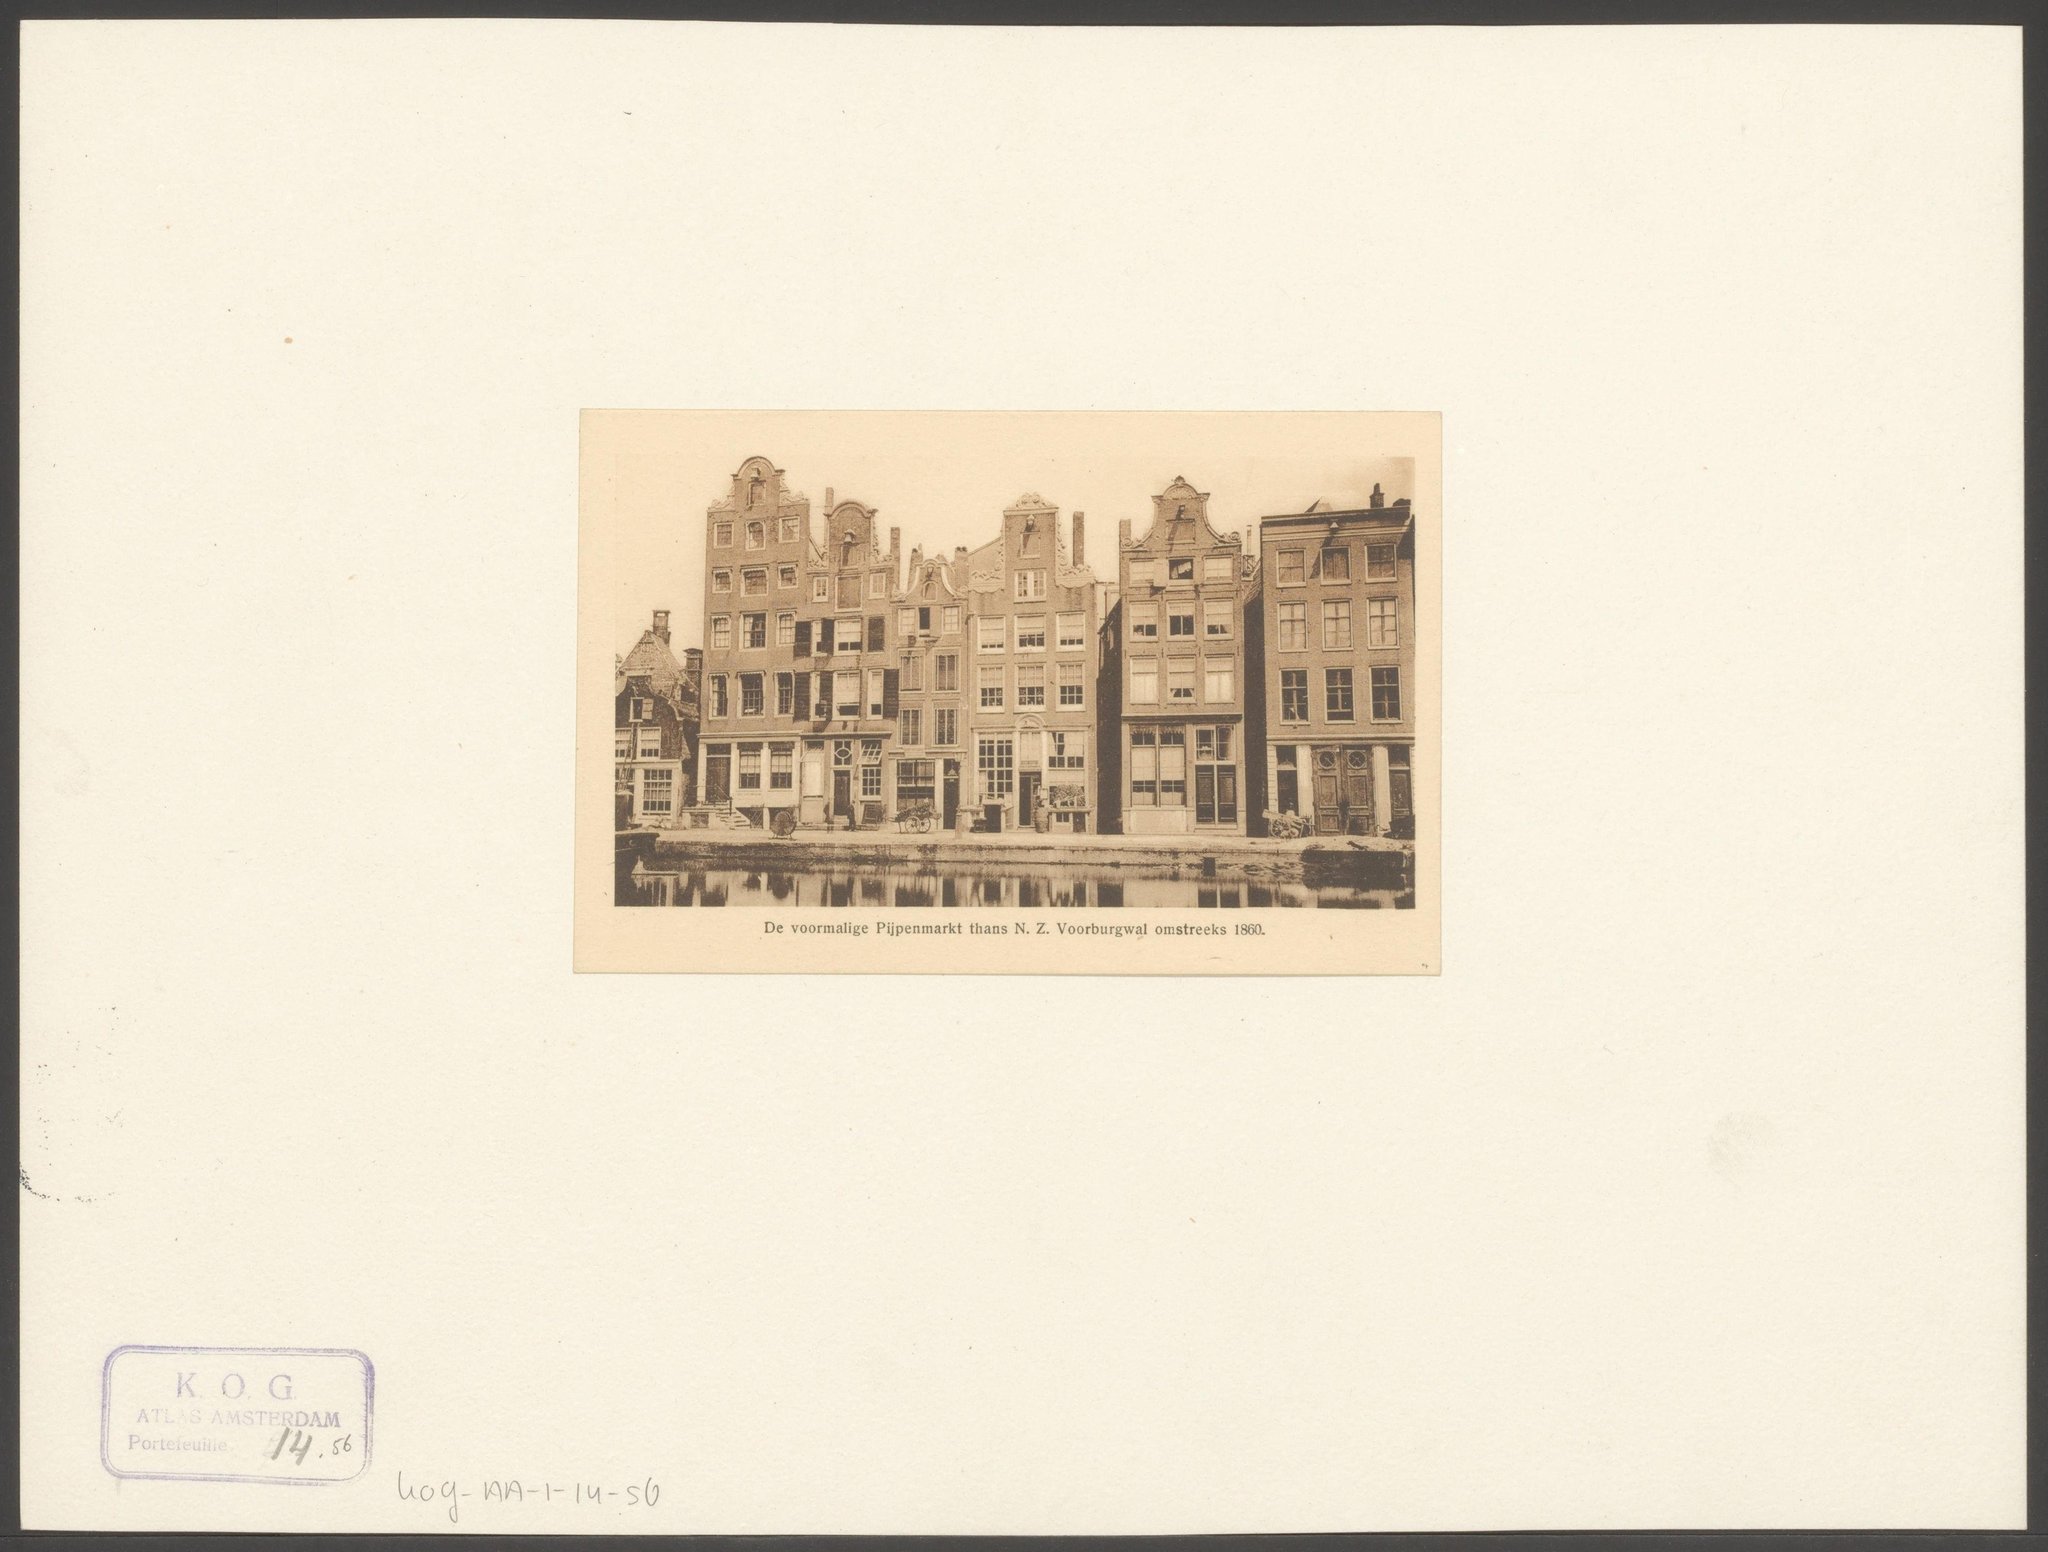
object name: photomechanical print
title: Gezicht op de Nieuwezijds Voorburgwal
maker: Anonymous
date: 1905-1930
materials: cardboard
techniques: photograph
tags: city-view in general; 'veduta', canal, the usual house or row of houses, street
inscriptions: collector's mark: ‘8’ Lugt 1641b, collector's mark: ‘14.56’ Lugt 1641b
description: Onderwerpsrubriek binnen de Atlas Amsterdam: Verhulststraat (Johannes), Viaducten, Vierwindenstraat, Vinkenbuurt, Vinkenpad, Vinkenstraat, Vischsteeg, Vliegendesteeg, Voetboogstraat, Volewijk, Vondelstraat, Voorburgwal (N.Z.).